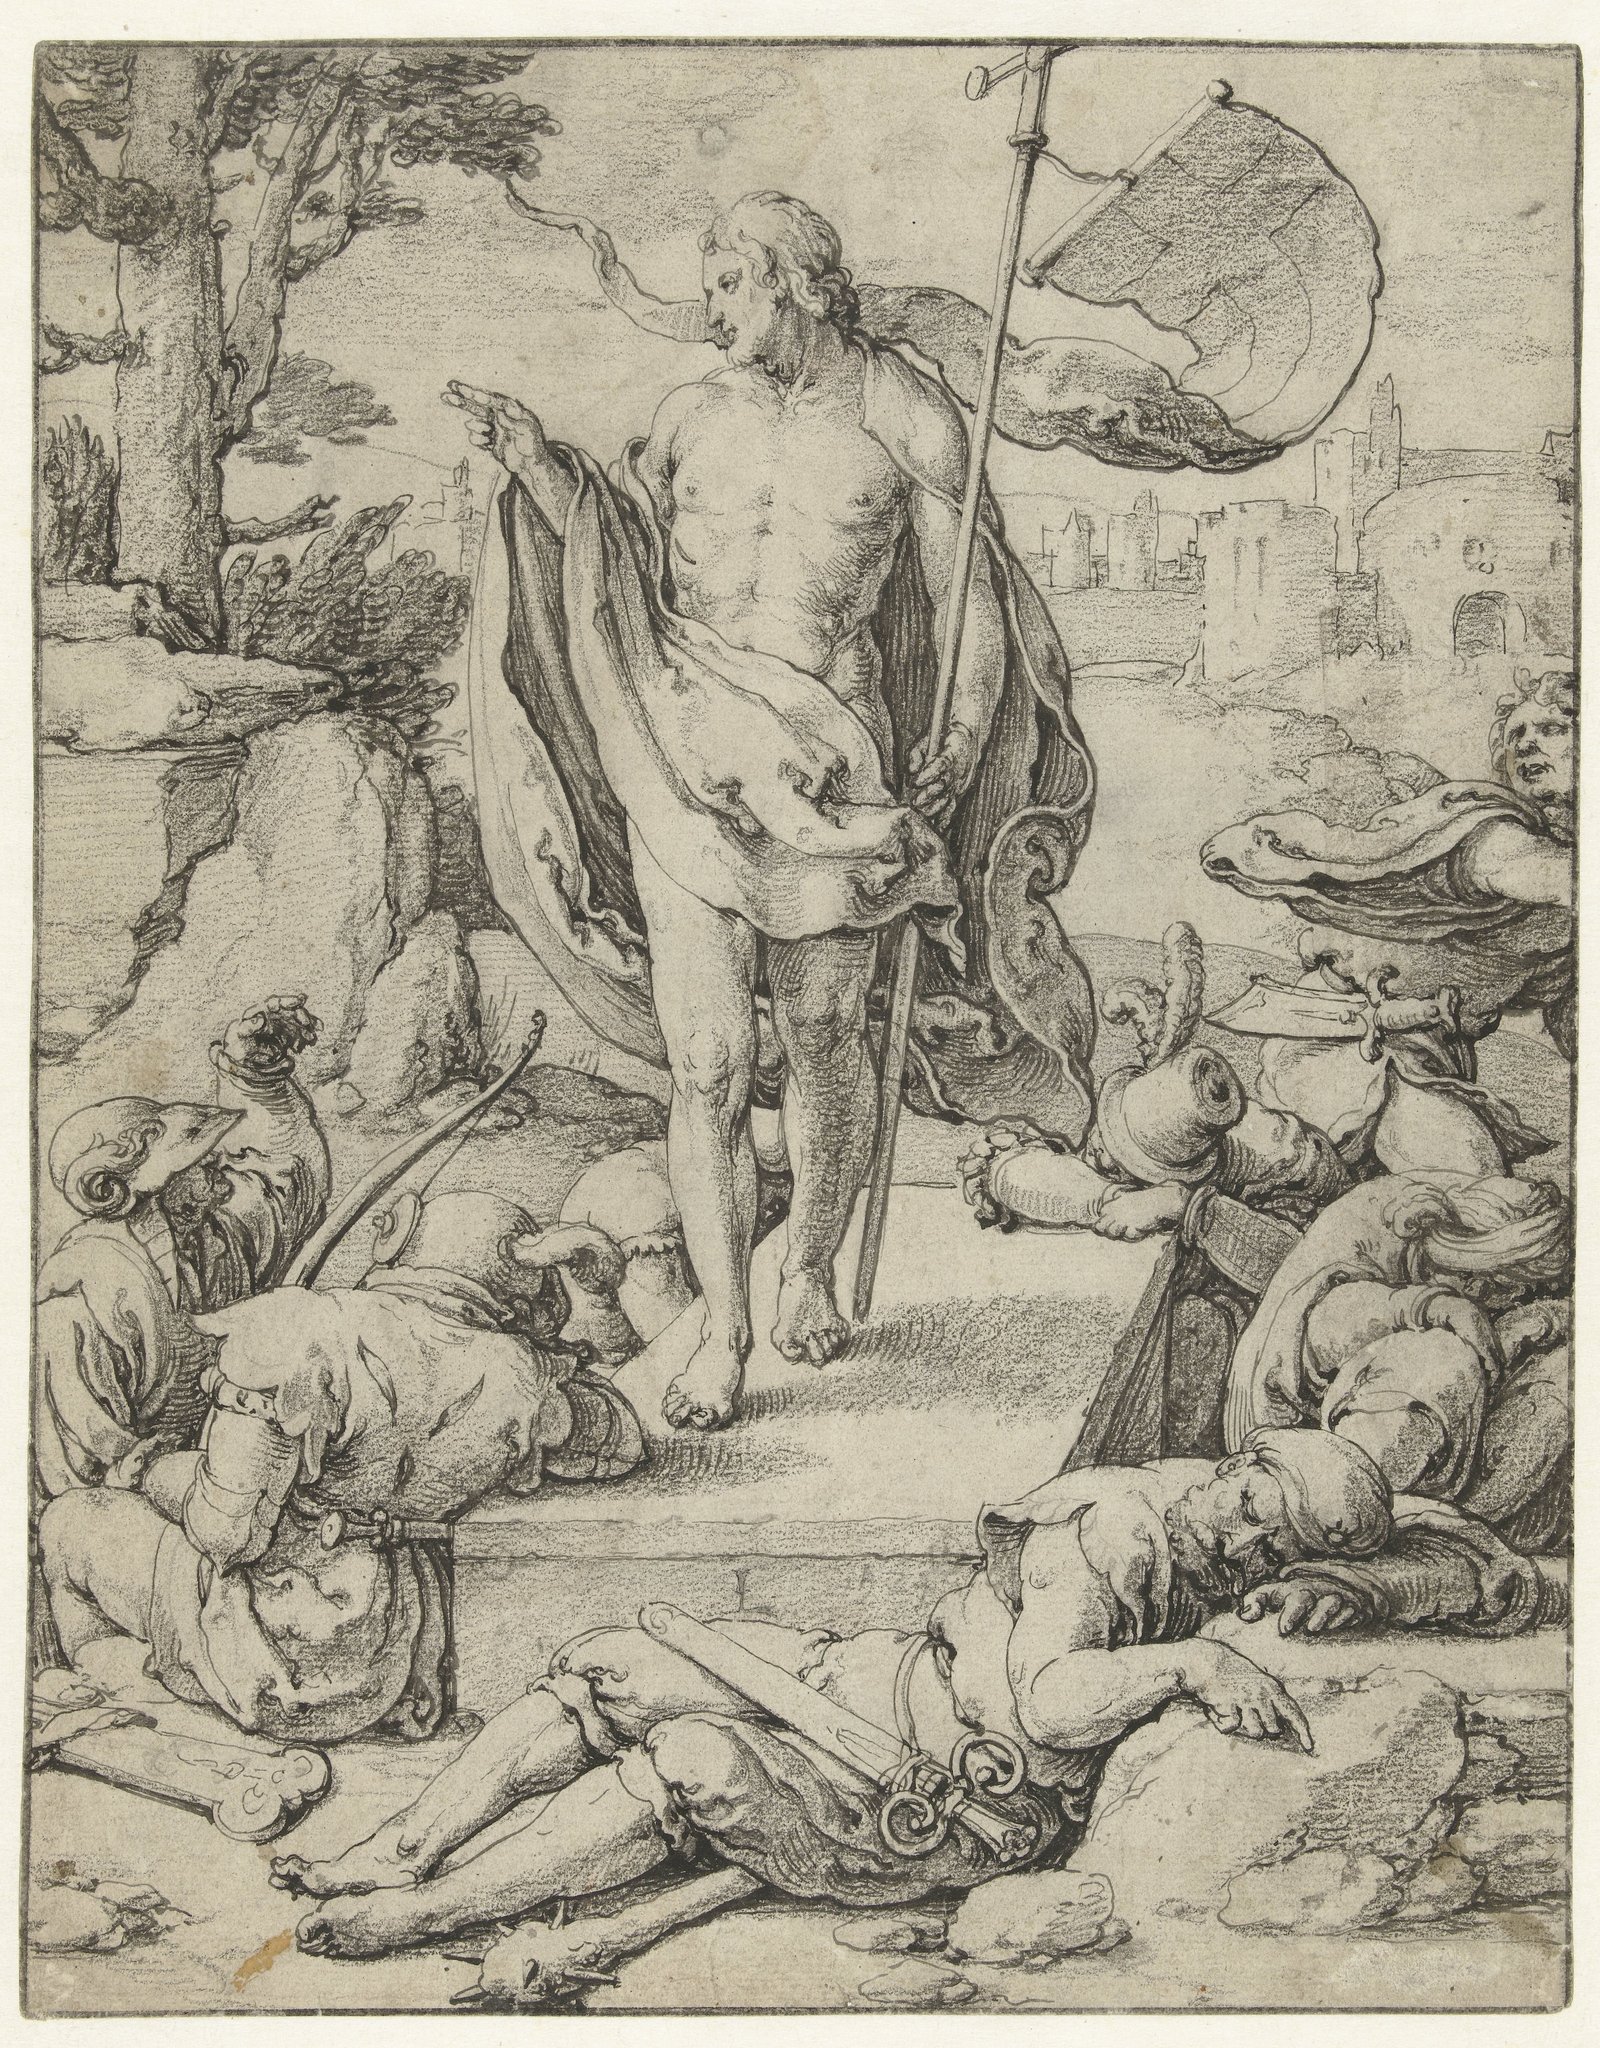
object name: drawing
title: De opstanding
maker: lucas van leyden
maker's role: draughtsman, painter, print maker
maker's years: 1494-1533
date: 1529-1533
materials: chalk, paper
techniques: brush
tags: christ, usually holding a banner, arises from the grave; often combined with sleeping and/or frightened soldiers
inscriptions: signature and date: ‘L 1525(?)’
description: De opstanding, ontwerp voor een glasruit.